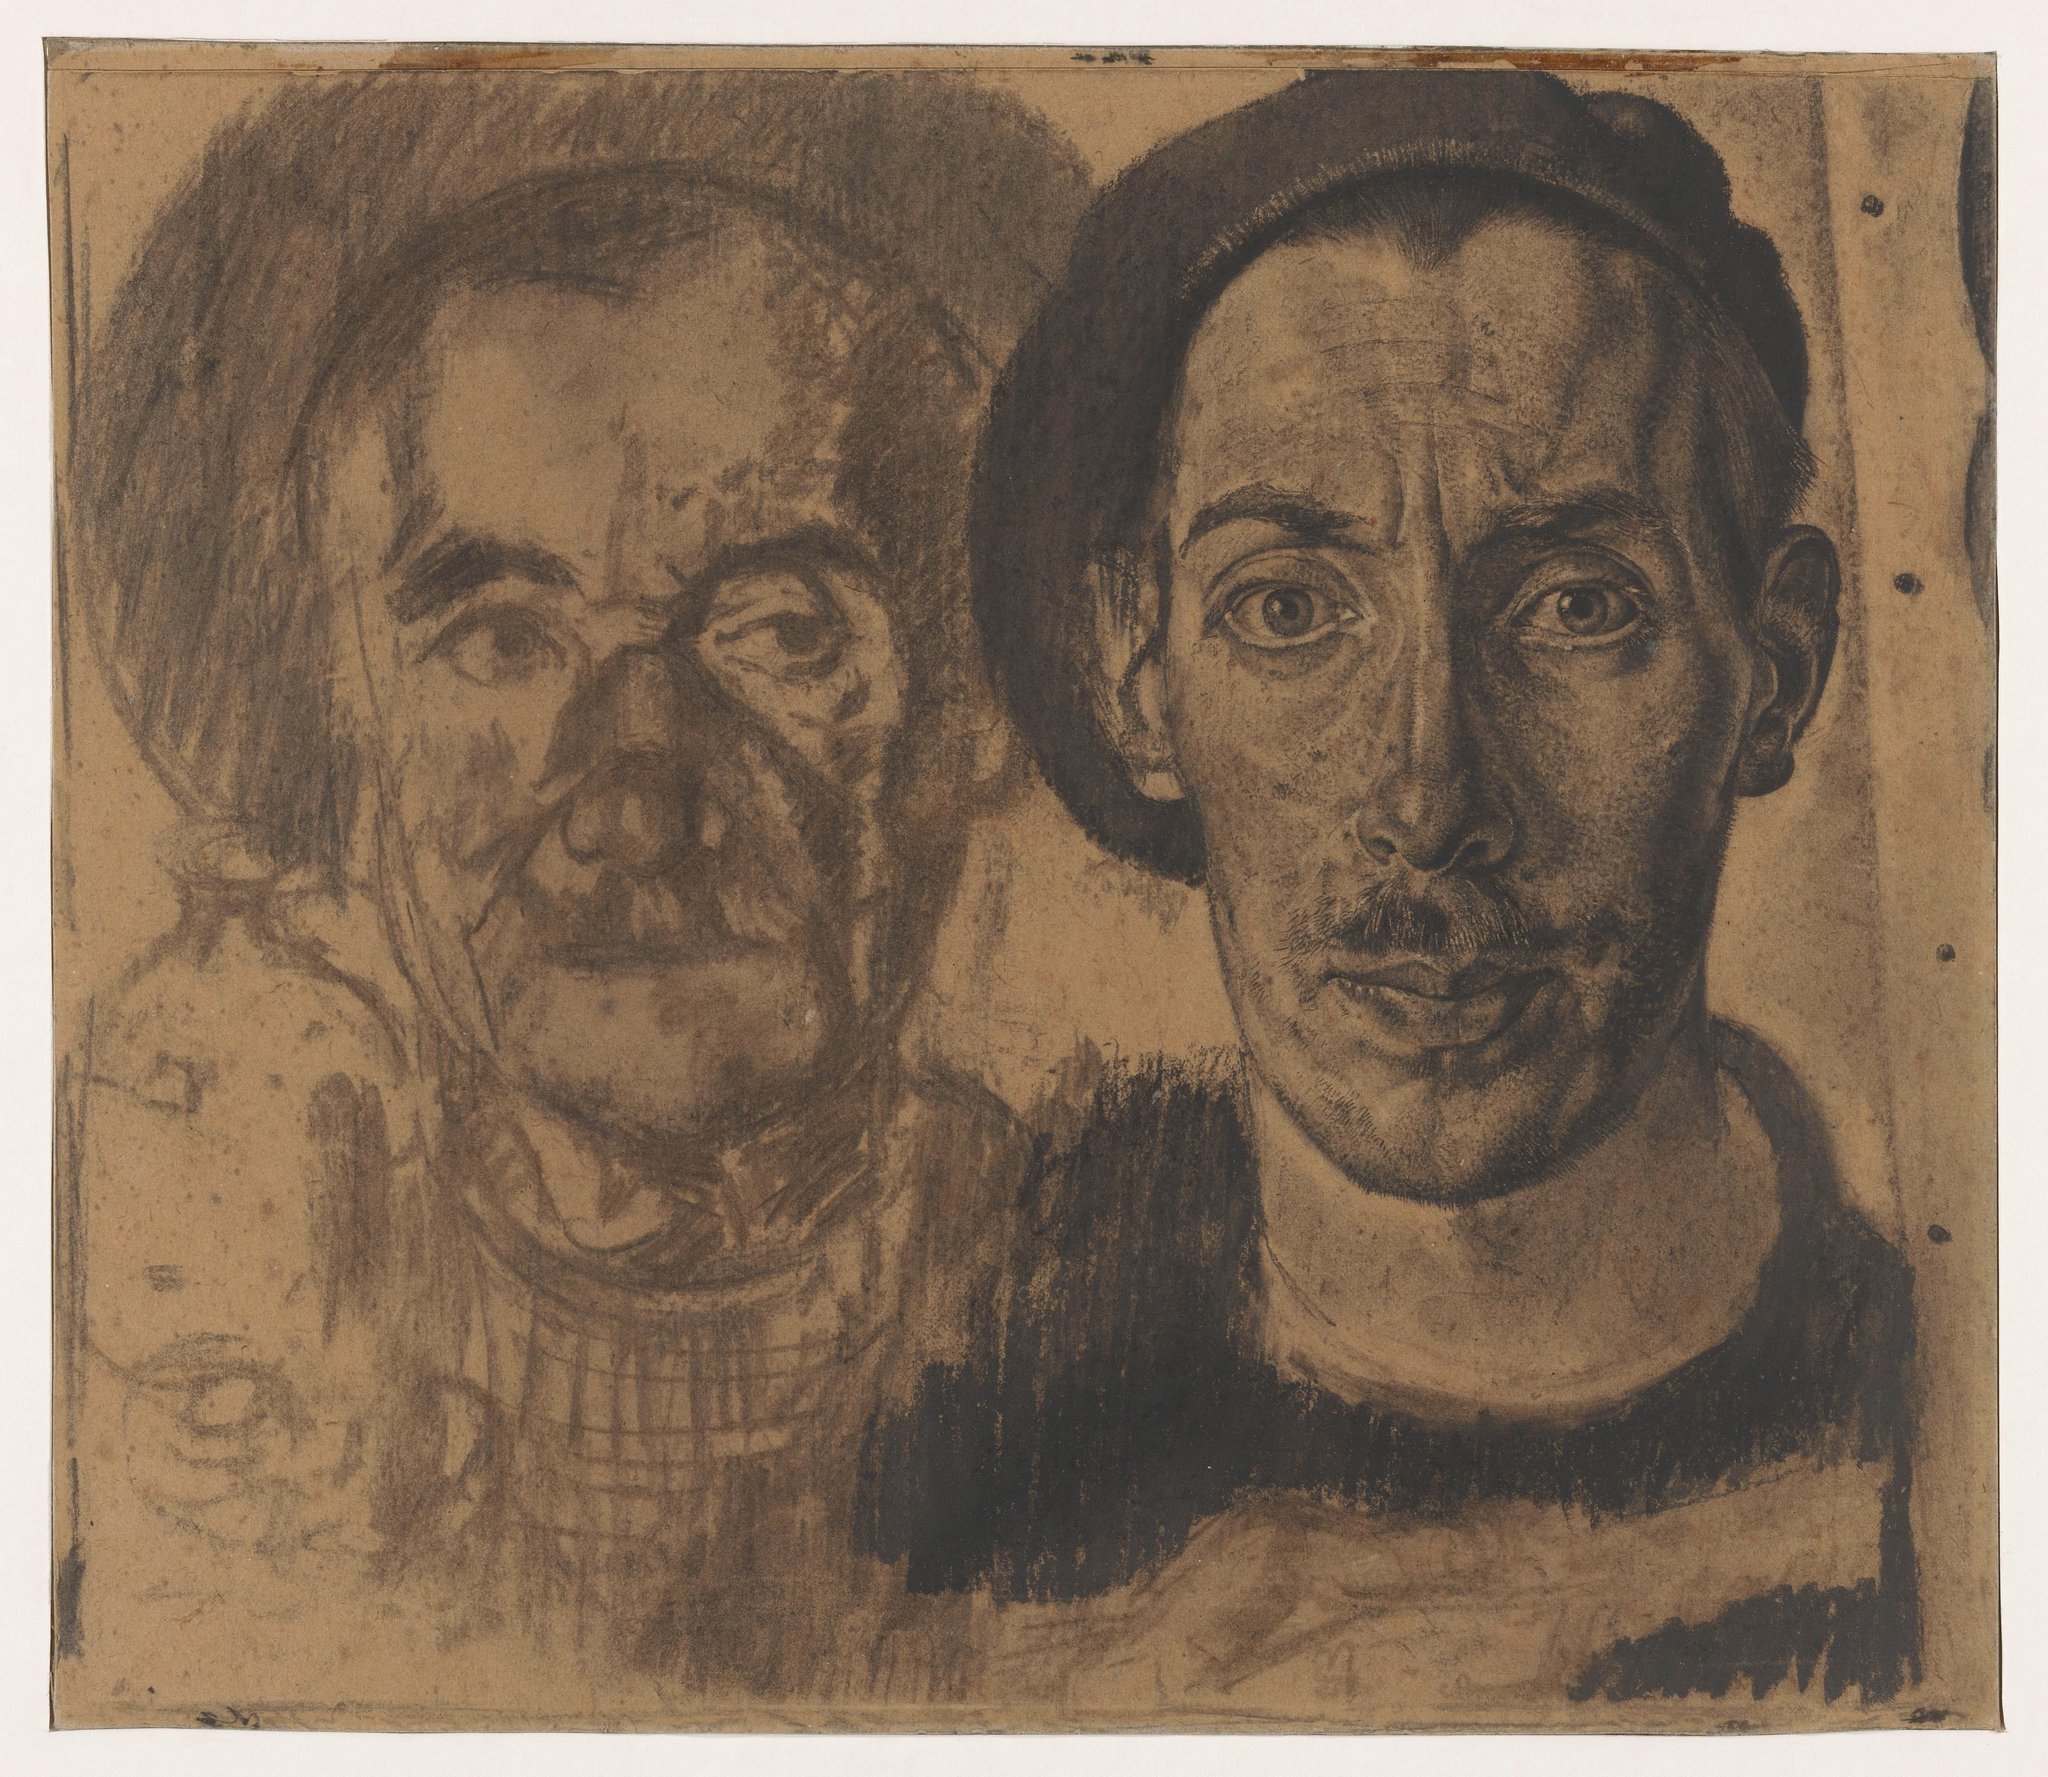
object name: drawing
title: Portret van Libbe en Dick Ket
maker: dick ket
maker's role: draughtsman, print maker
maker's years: 1902-1940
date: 1939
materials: cardboard, chalk, charcoal, ink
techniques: brush, pen, scoring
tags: den helder, print maker, draughtsman, dick ket, historical persons, father and son(s) (family group), portrait, self-portrait of draughtsman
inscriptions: collector's mark: Lugt 2228